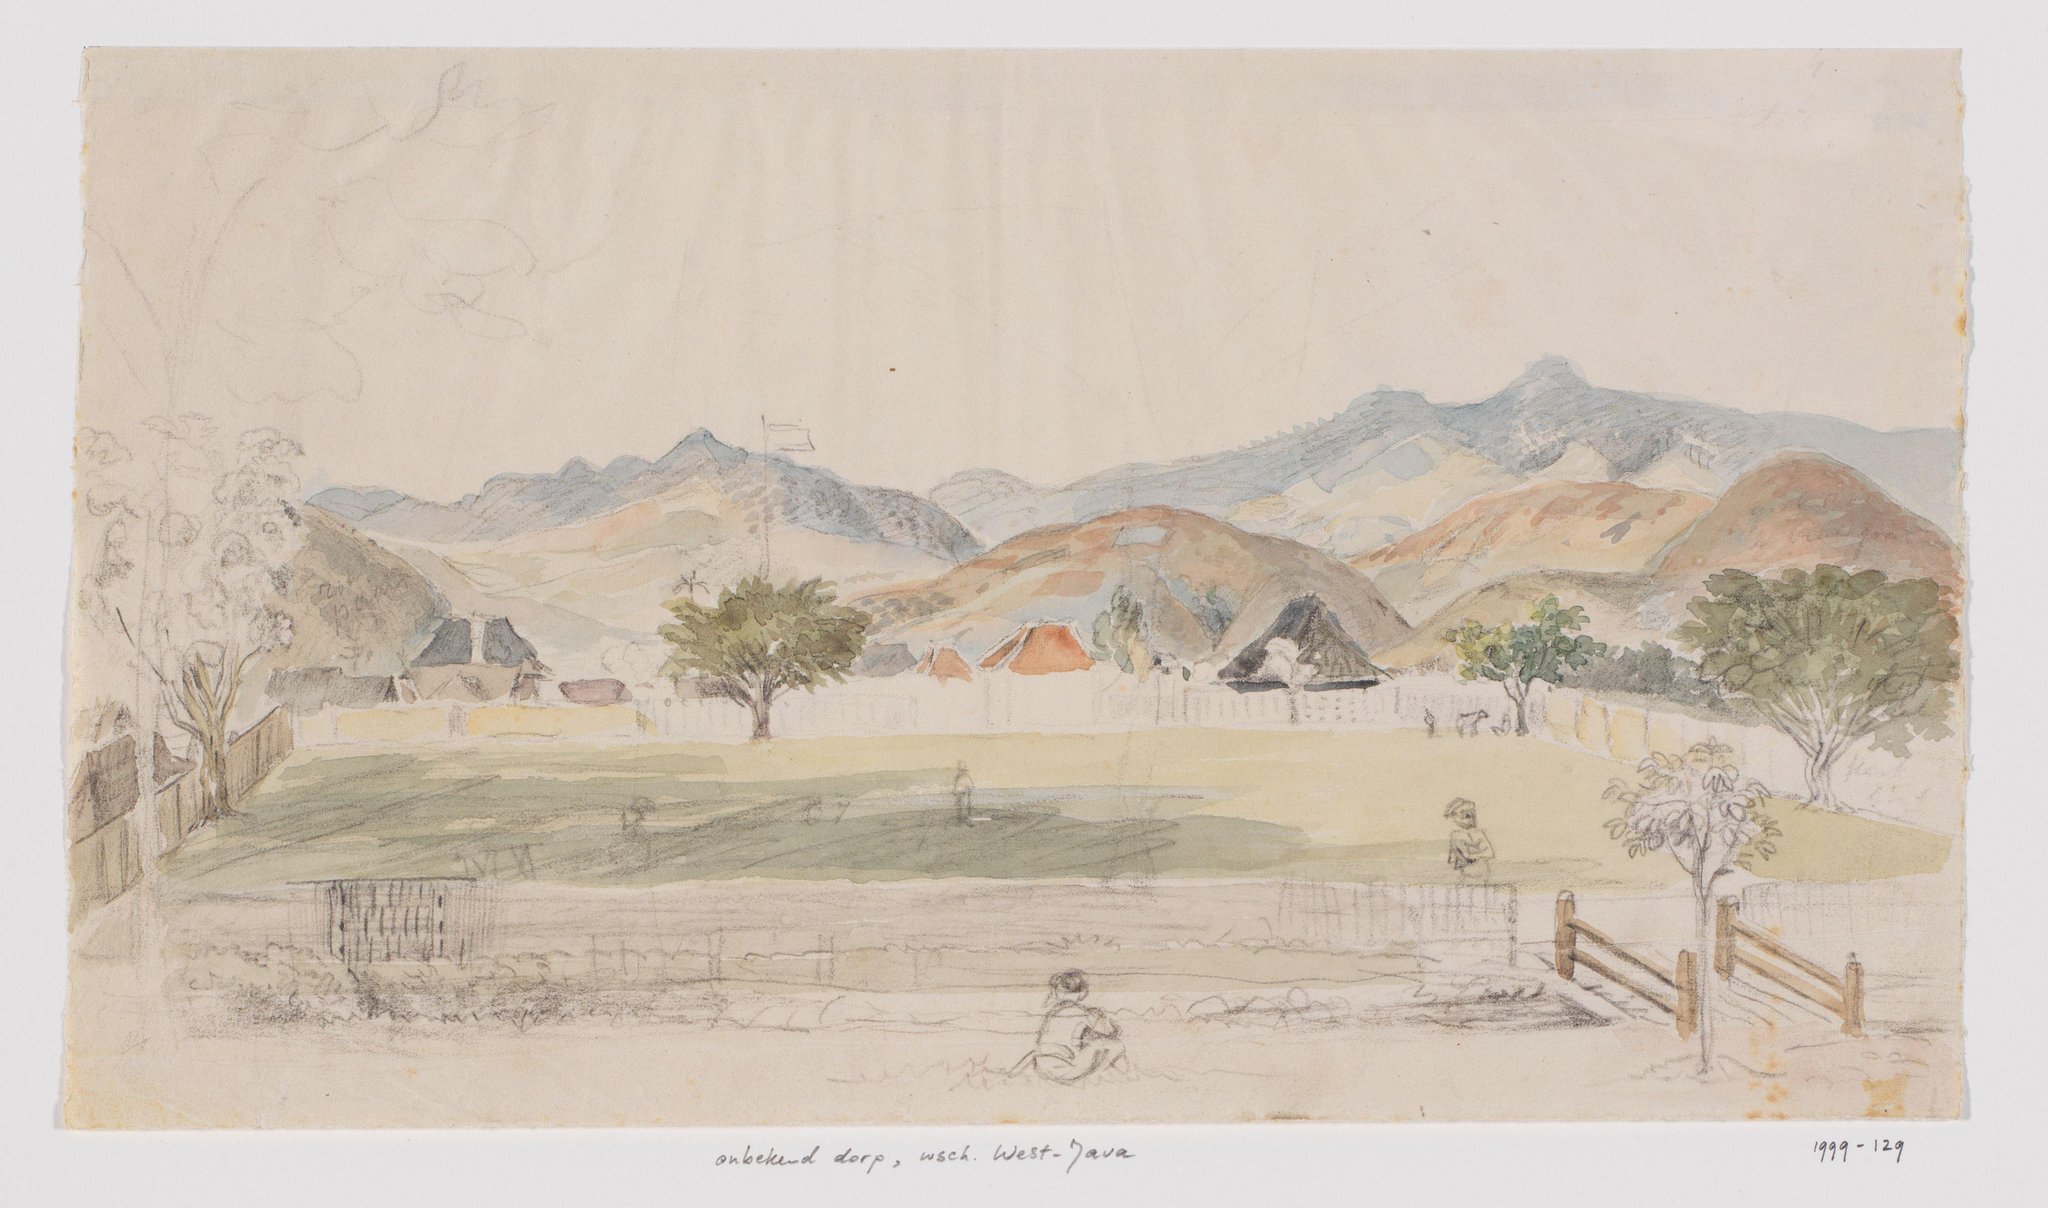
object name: topographical view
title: Landschap en gezicht op huizen en dorpsplein, West-Java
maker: adrianus johannes bik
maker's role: draughtsman, print maker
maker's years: 1790-1872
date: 1816-1846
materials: chalk, paper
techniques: brush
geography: java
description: artikel over deze collectie in Bulletin van het Rijksmuseum 49 [2001], nr. 4, pp 342 e.v., p. 352, afb. 10